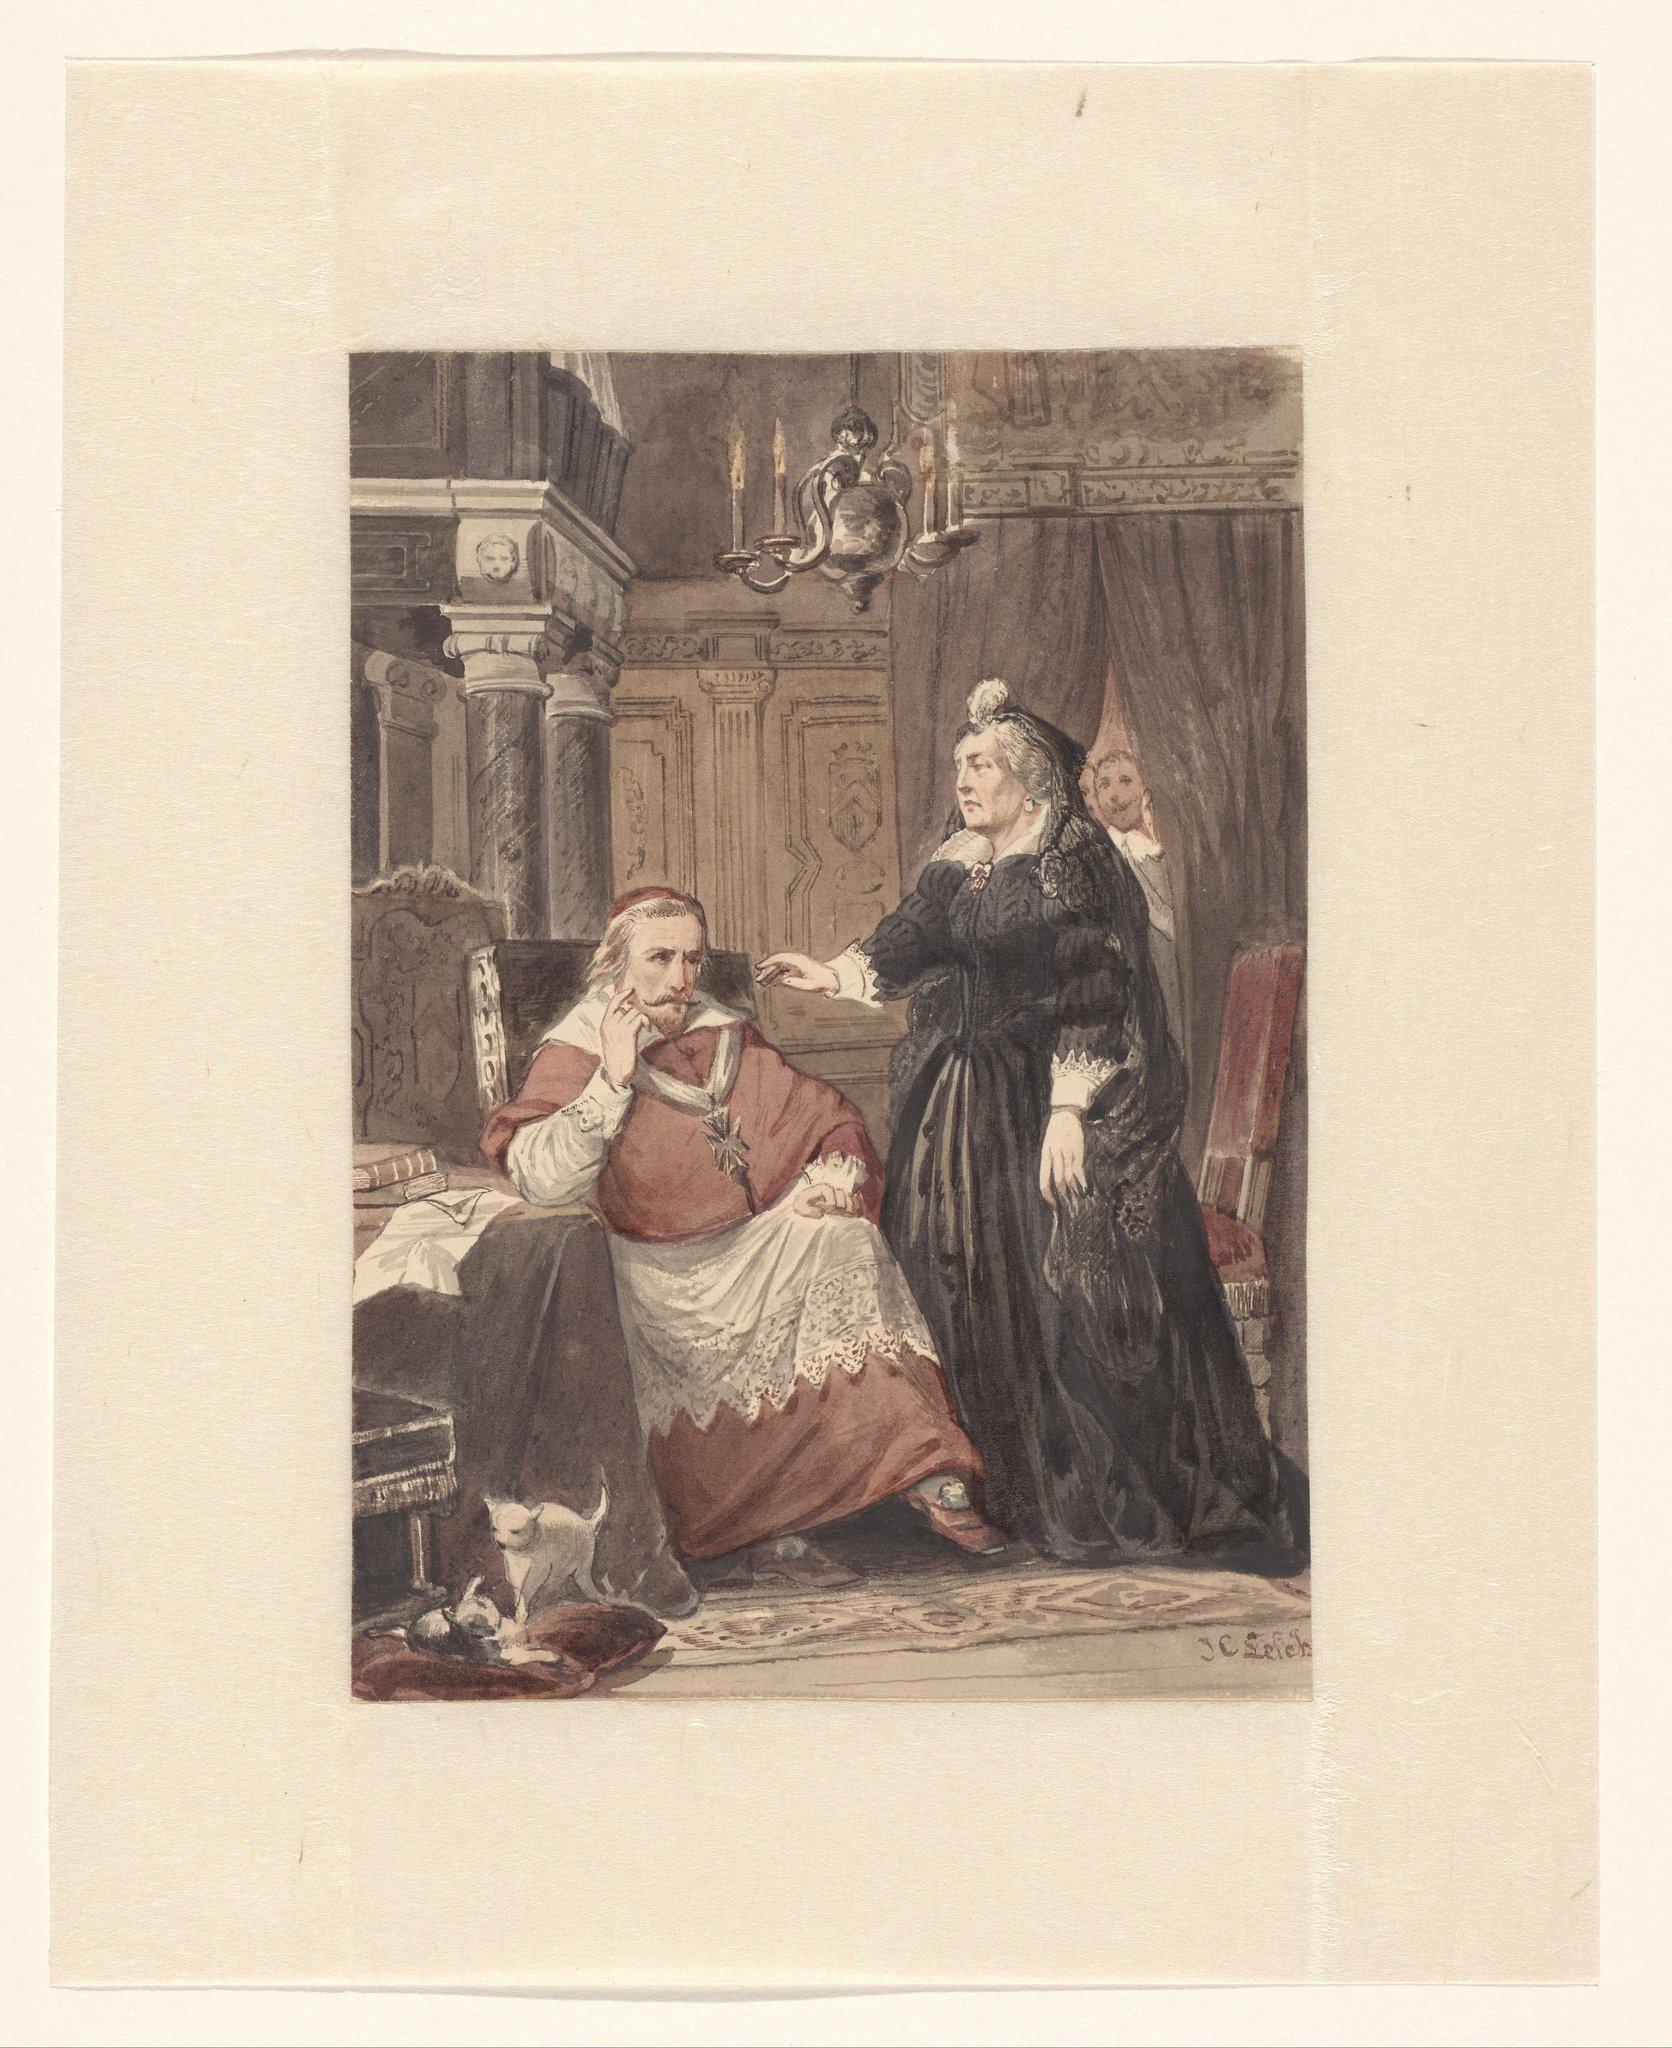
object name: drawing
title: Twee personen in een interieur, mogelijk Maria de Medici en kardinaal de Richelieu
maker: johan coenraad leich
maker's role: draughtsman, print maker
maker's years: 1823-1890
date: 1833-1890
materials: ink, paper, pencil, watercolor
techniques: brush, pen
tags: cologne, print maker, maria de' medici, armand-jean du plessis hertog van richelieu, interior of the house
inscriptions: collector's mark: Lugt 2228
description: De man, mogelijk kardinaal de Richelieu, zit in een stoel. Naast hem staat een vrouw, mogelijk Maria de Medici. In de achtergrond spiekt een man van achter een gordijn naar de twee personen.